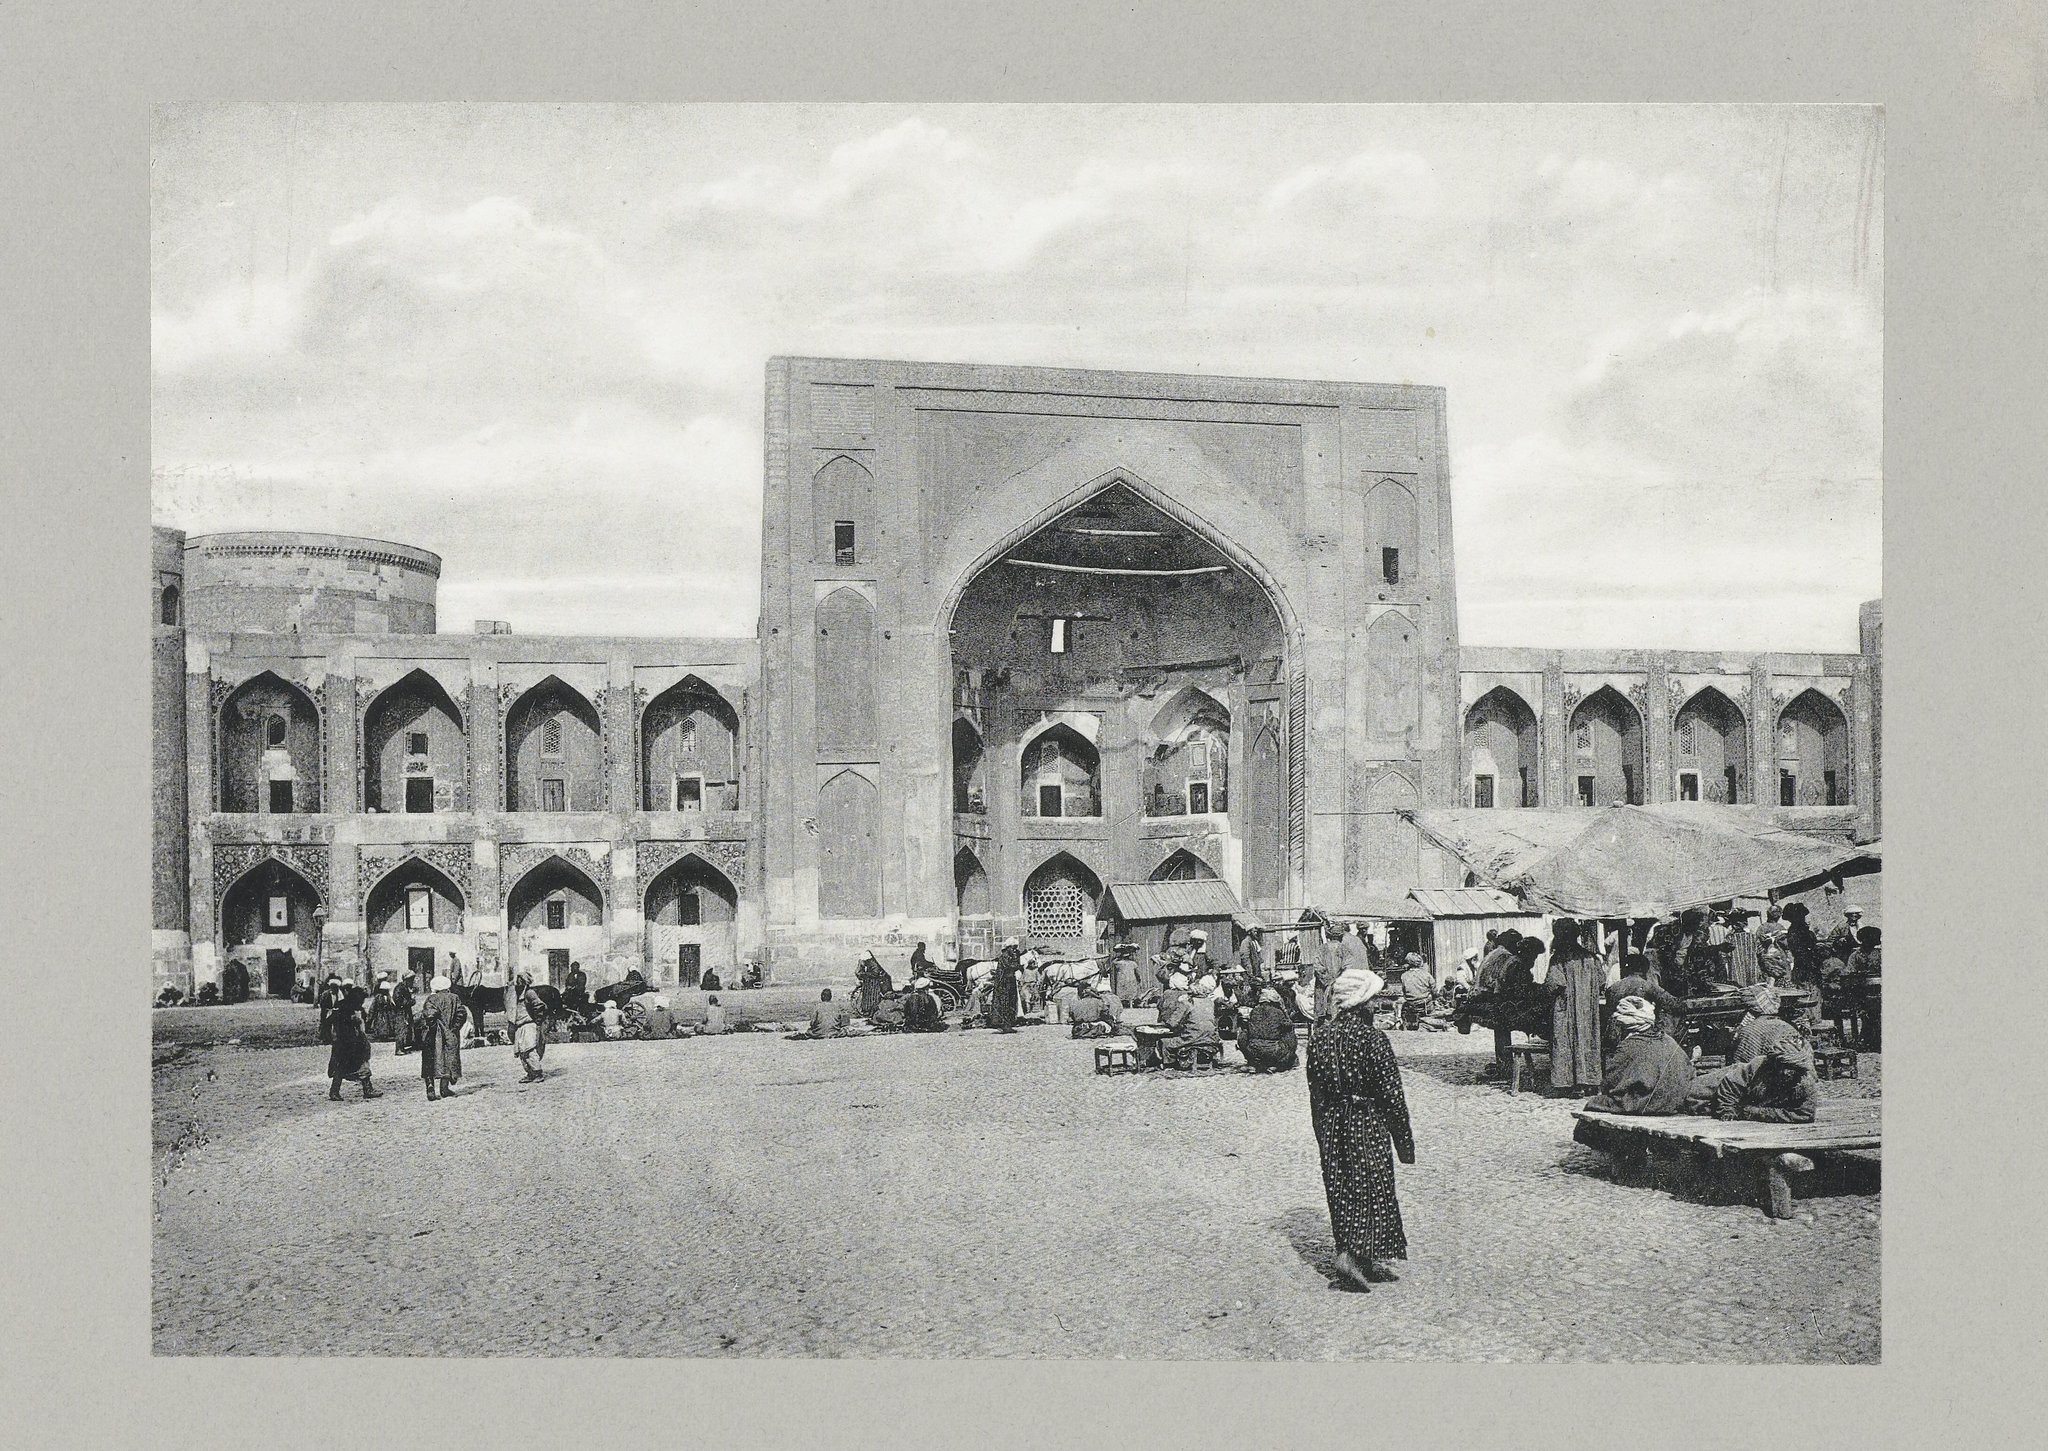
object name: photomechanical print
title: Moskee met cellen voor studenten op de Marktplaats te Samarkand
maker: Anonymous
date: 1895-1915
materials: cardboard, paper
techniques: photograph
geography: samarqand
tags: samarqand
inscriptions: annotation: ‘10. Moskee met cellen voor de studenten op de Marktplaats te Samarkand.’